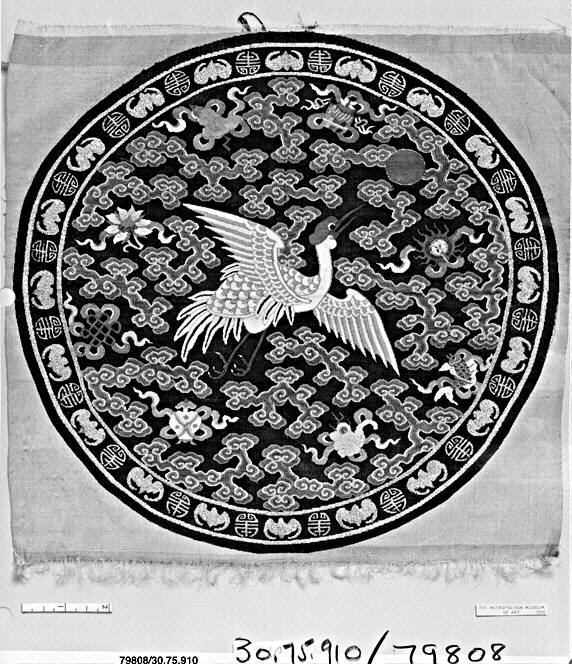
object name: insignia medallion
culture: chinese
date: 1801-1900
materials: metal thread, silk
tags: phoenix